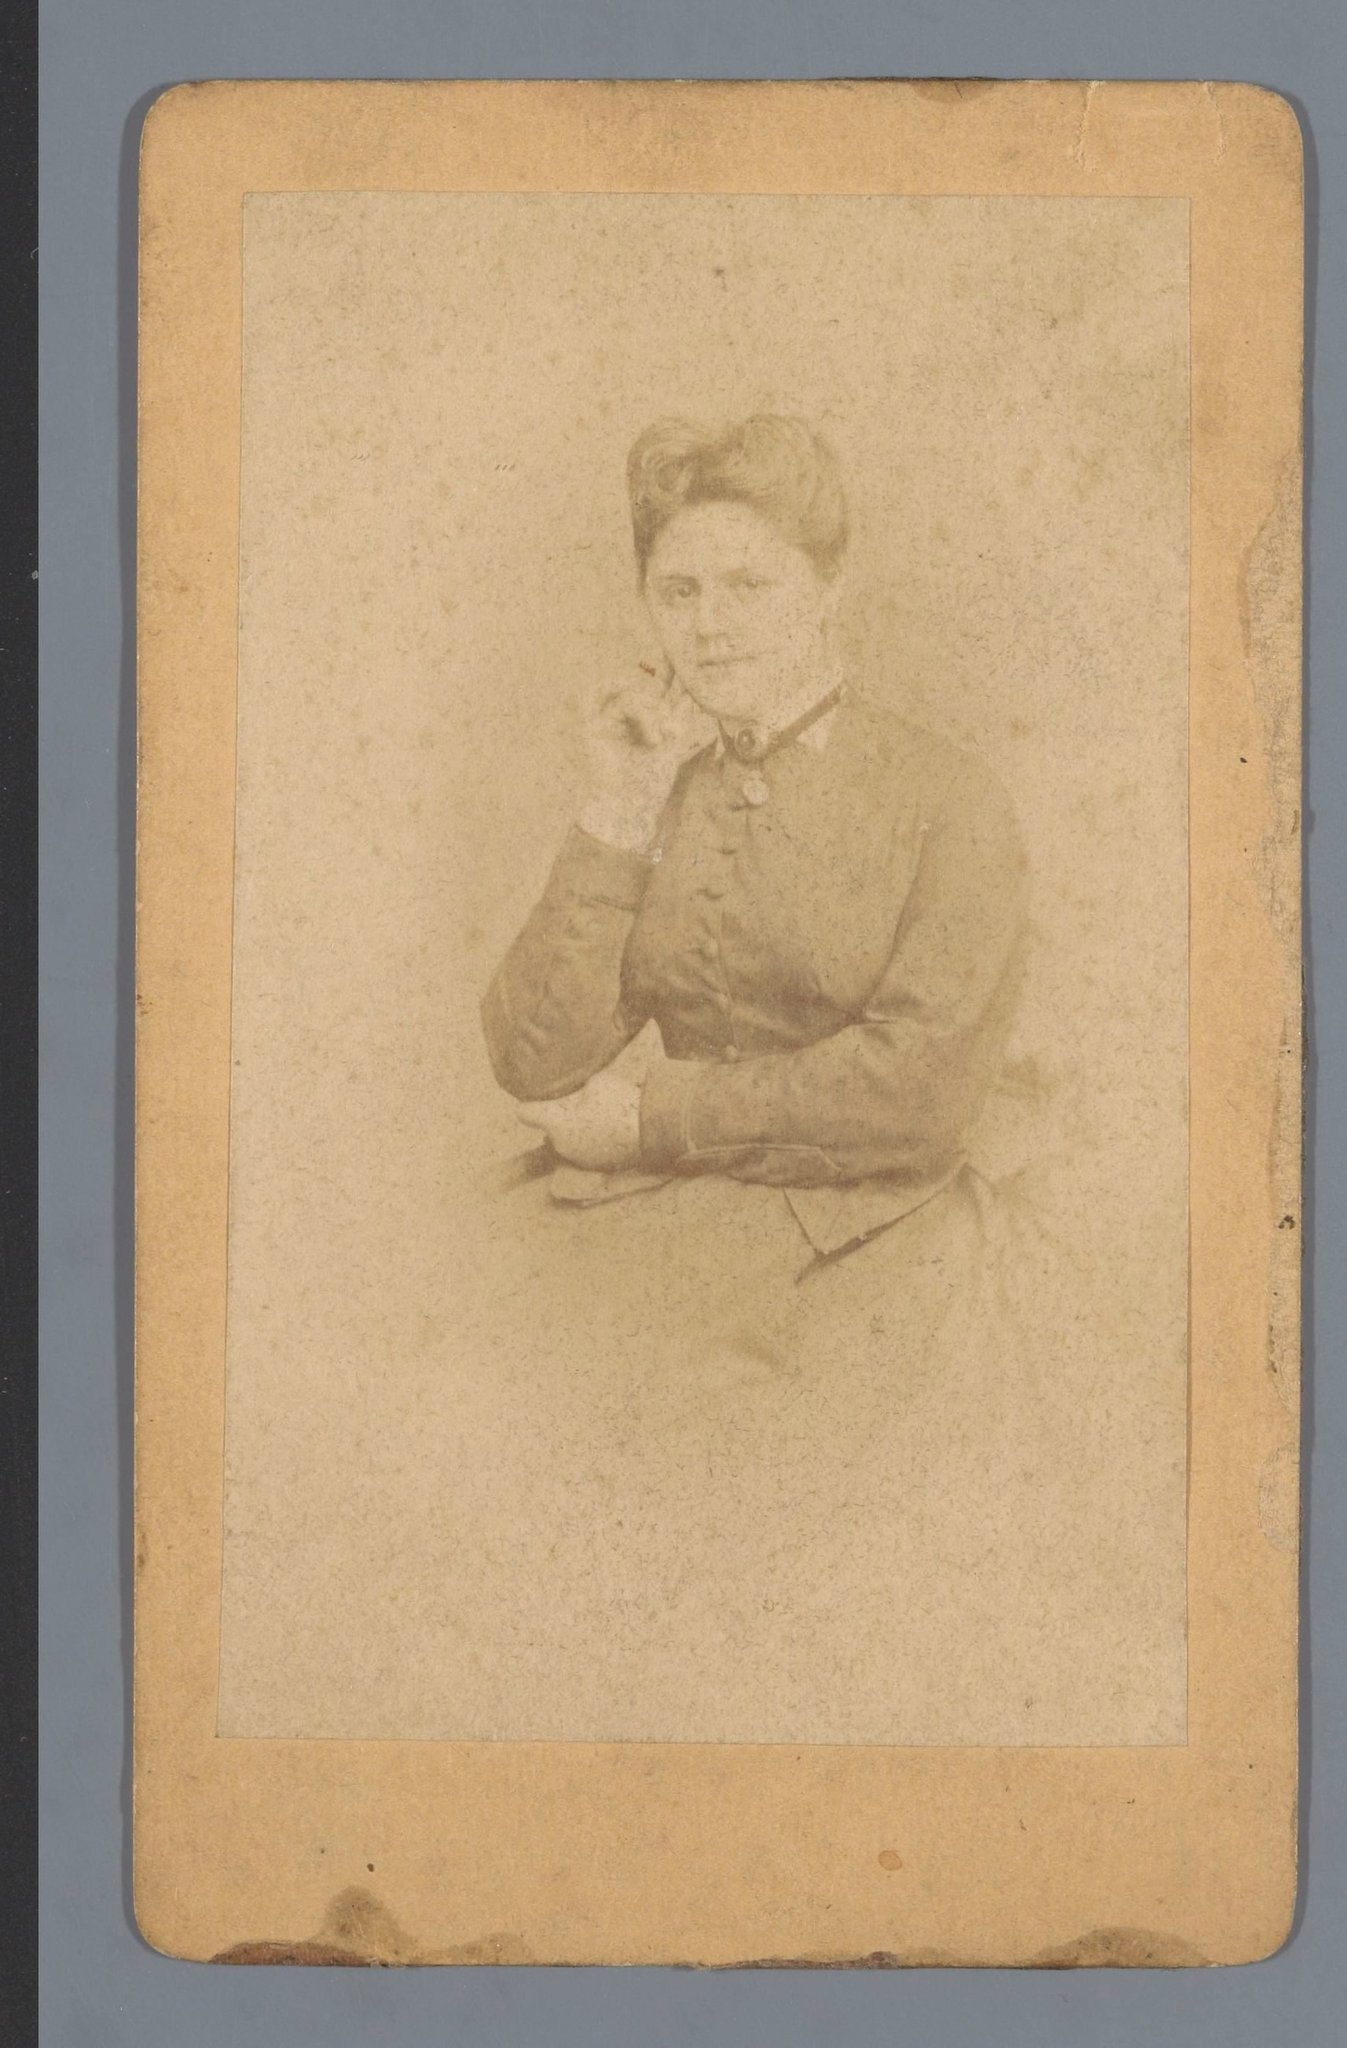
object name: carte de visite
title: Portret van een onbekende vrouw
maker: Anonymous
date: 1850-1900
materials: cardboard, photographic support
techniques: albumen print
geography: dusseldorf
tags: historical persons not known by name - bb - woman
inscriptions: annotation: ‘UIT/ ALBUM/ VAN/ MEVR./ LAERNOES’, address: ‘Louis Stü[...]/ Hof-Photograph/ Düsseldorf/ Casernenstrasse No 10.’